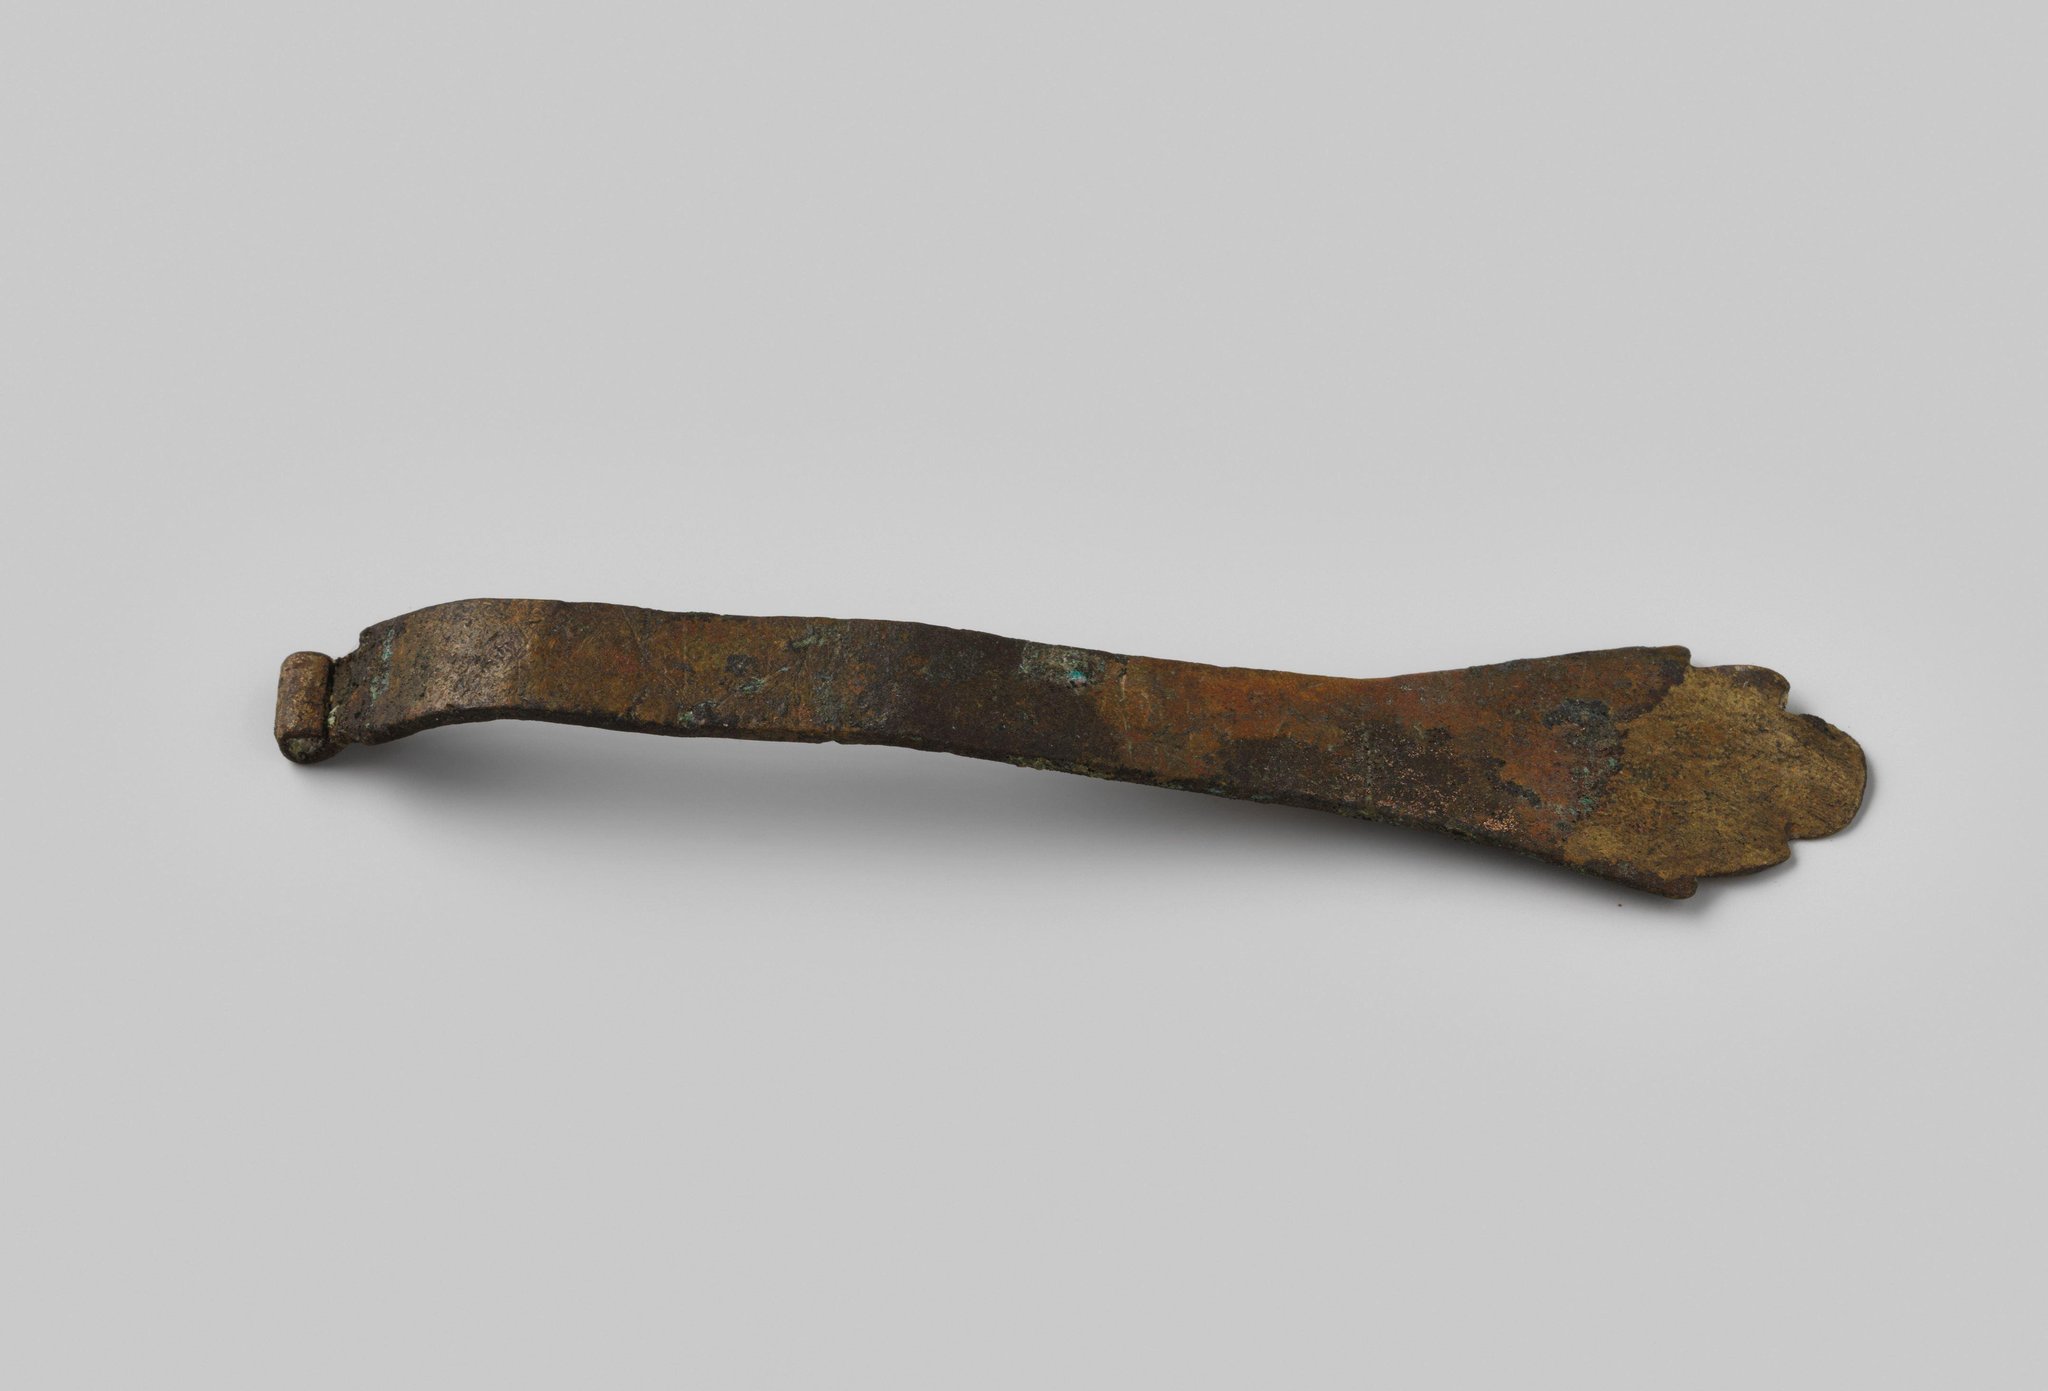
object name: helve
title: Koperen steel uit het wrak van de Oost-Indiëvaarder Hollandia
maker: Anonymous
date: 1700-1743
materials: copper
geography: netherlands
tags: verenigde oostindische compagnie, hollandia (schip), annet